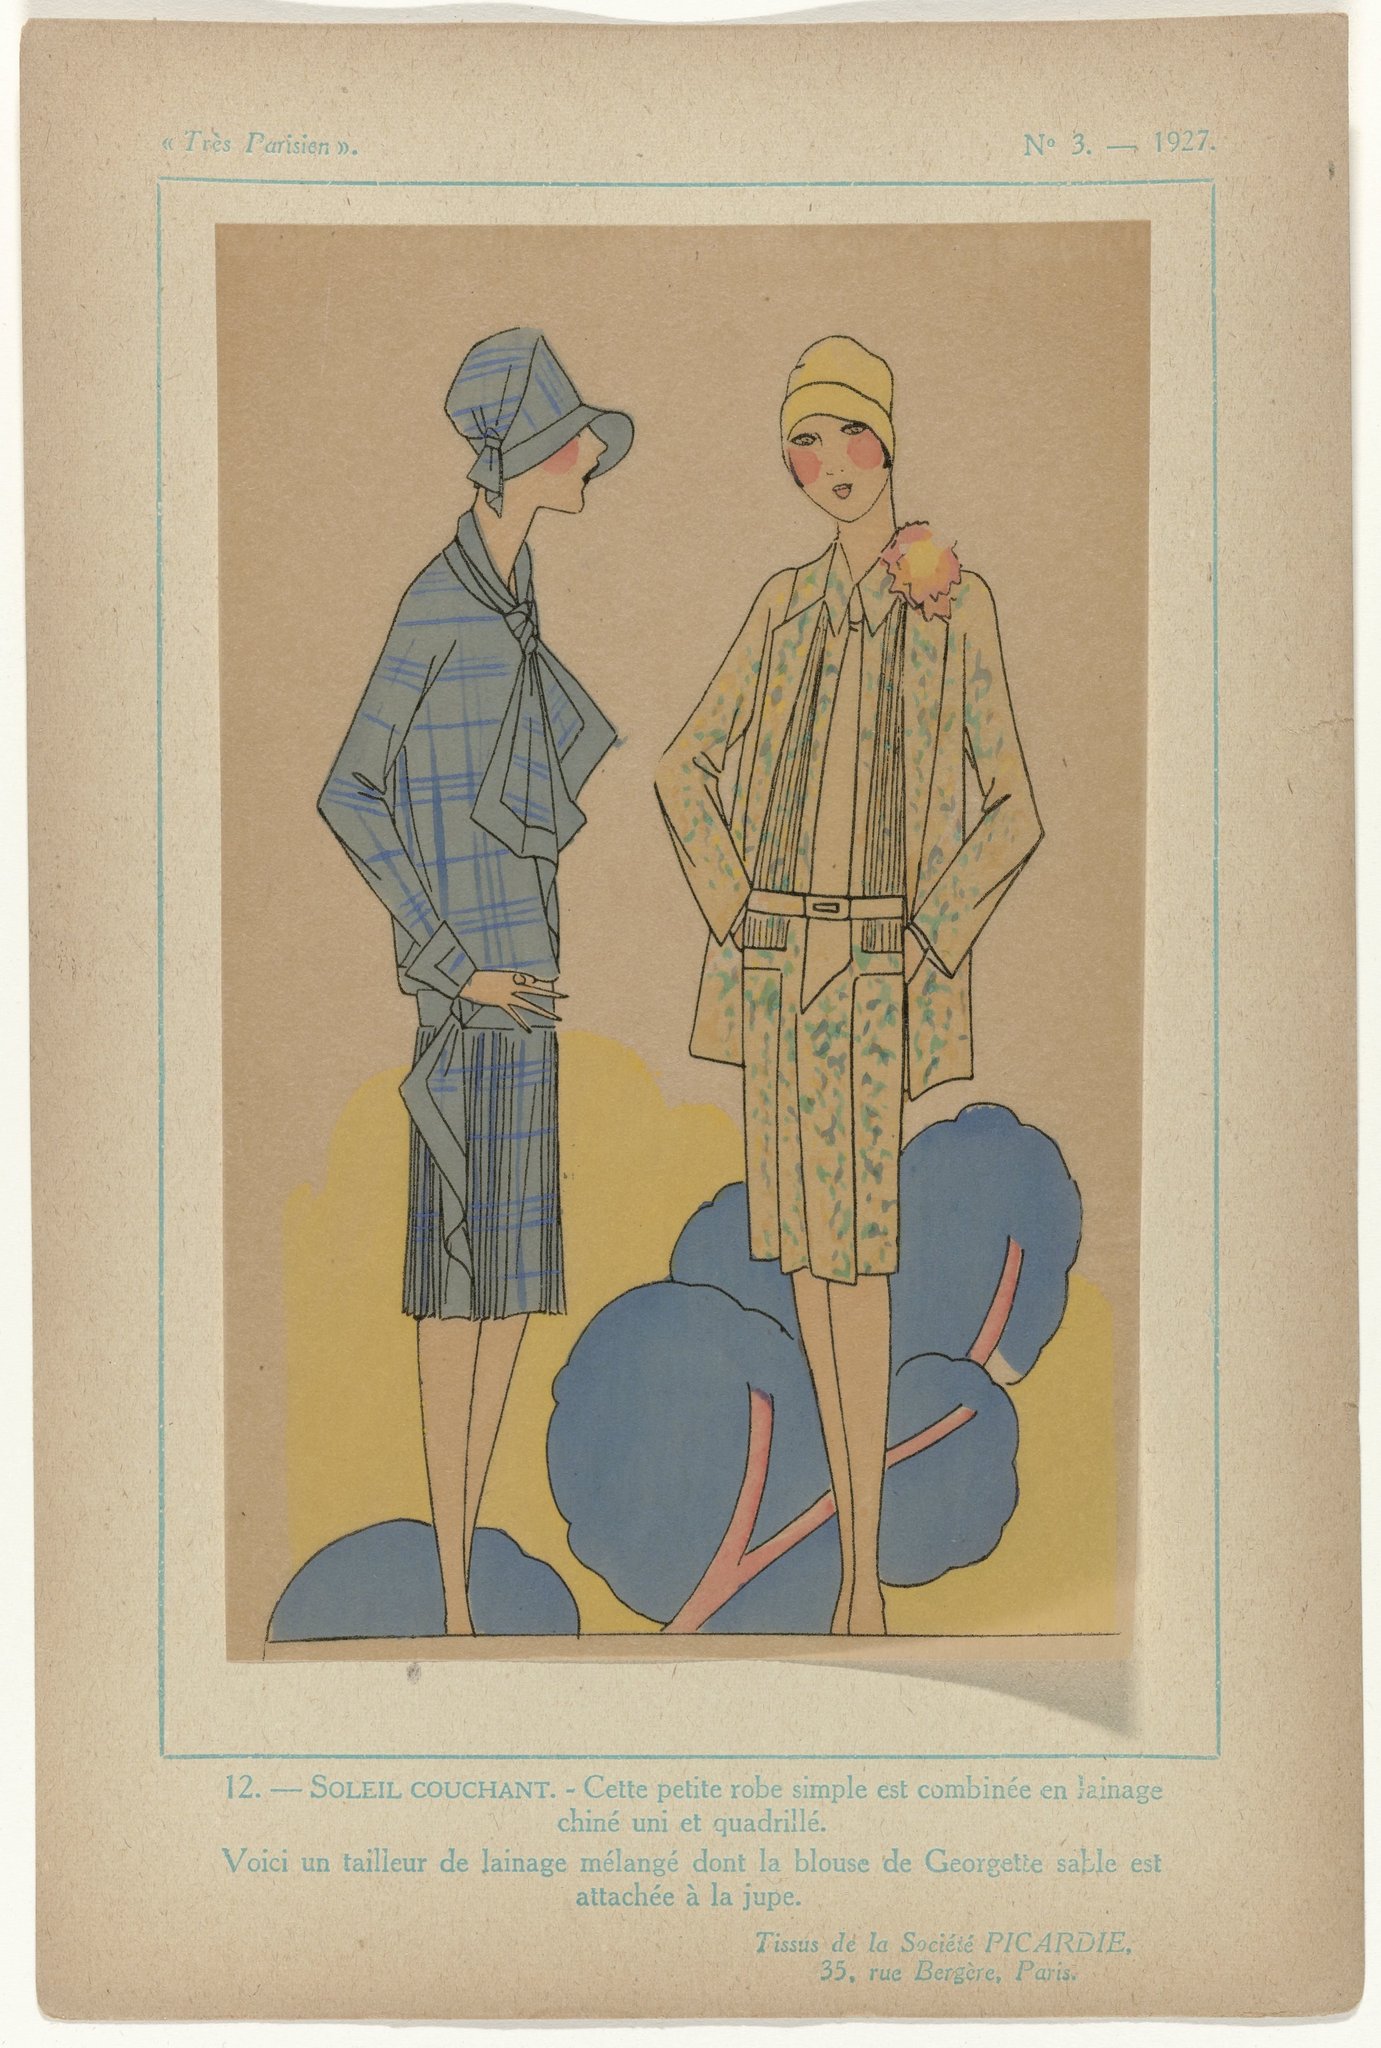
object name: fashion print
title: Très Parisien, 1927, No. 3, Pl. 12.- SOLEIL COUCHANT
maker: g-p. joumard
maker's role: publisher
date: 1927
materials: paper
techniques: hand coloring, letterpress printing, lithography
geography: paris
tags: dress, gown: day dress (+ women's clothes), ensembles of pieces of clothing (tailleur) (+ women's clothes), fashion plates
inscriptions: caption: ‘SOLEIL COUCHANT. - Cete petit robe simple est combinée en lainage chiné uni et quadrillé. Voici un tailleur de lainage mélangé dont la blouse de Georgette sable est attachée à la jupe.’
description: Japon in blauw-grijze ruit; tailleur van wol met blouse van Georgette. Prent uit het modetijdschrift Très Parisien...La Mode, Le Chic, L'Élégance (1920-1936)